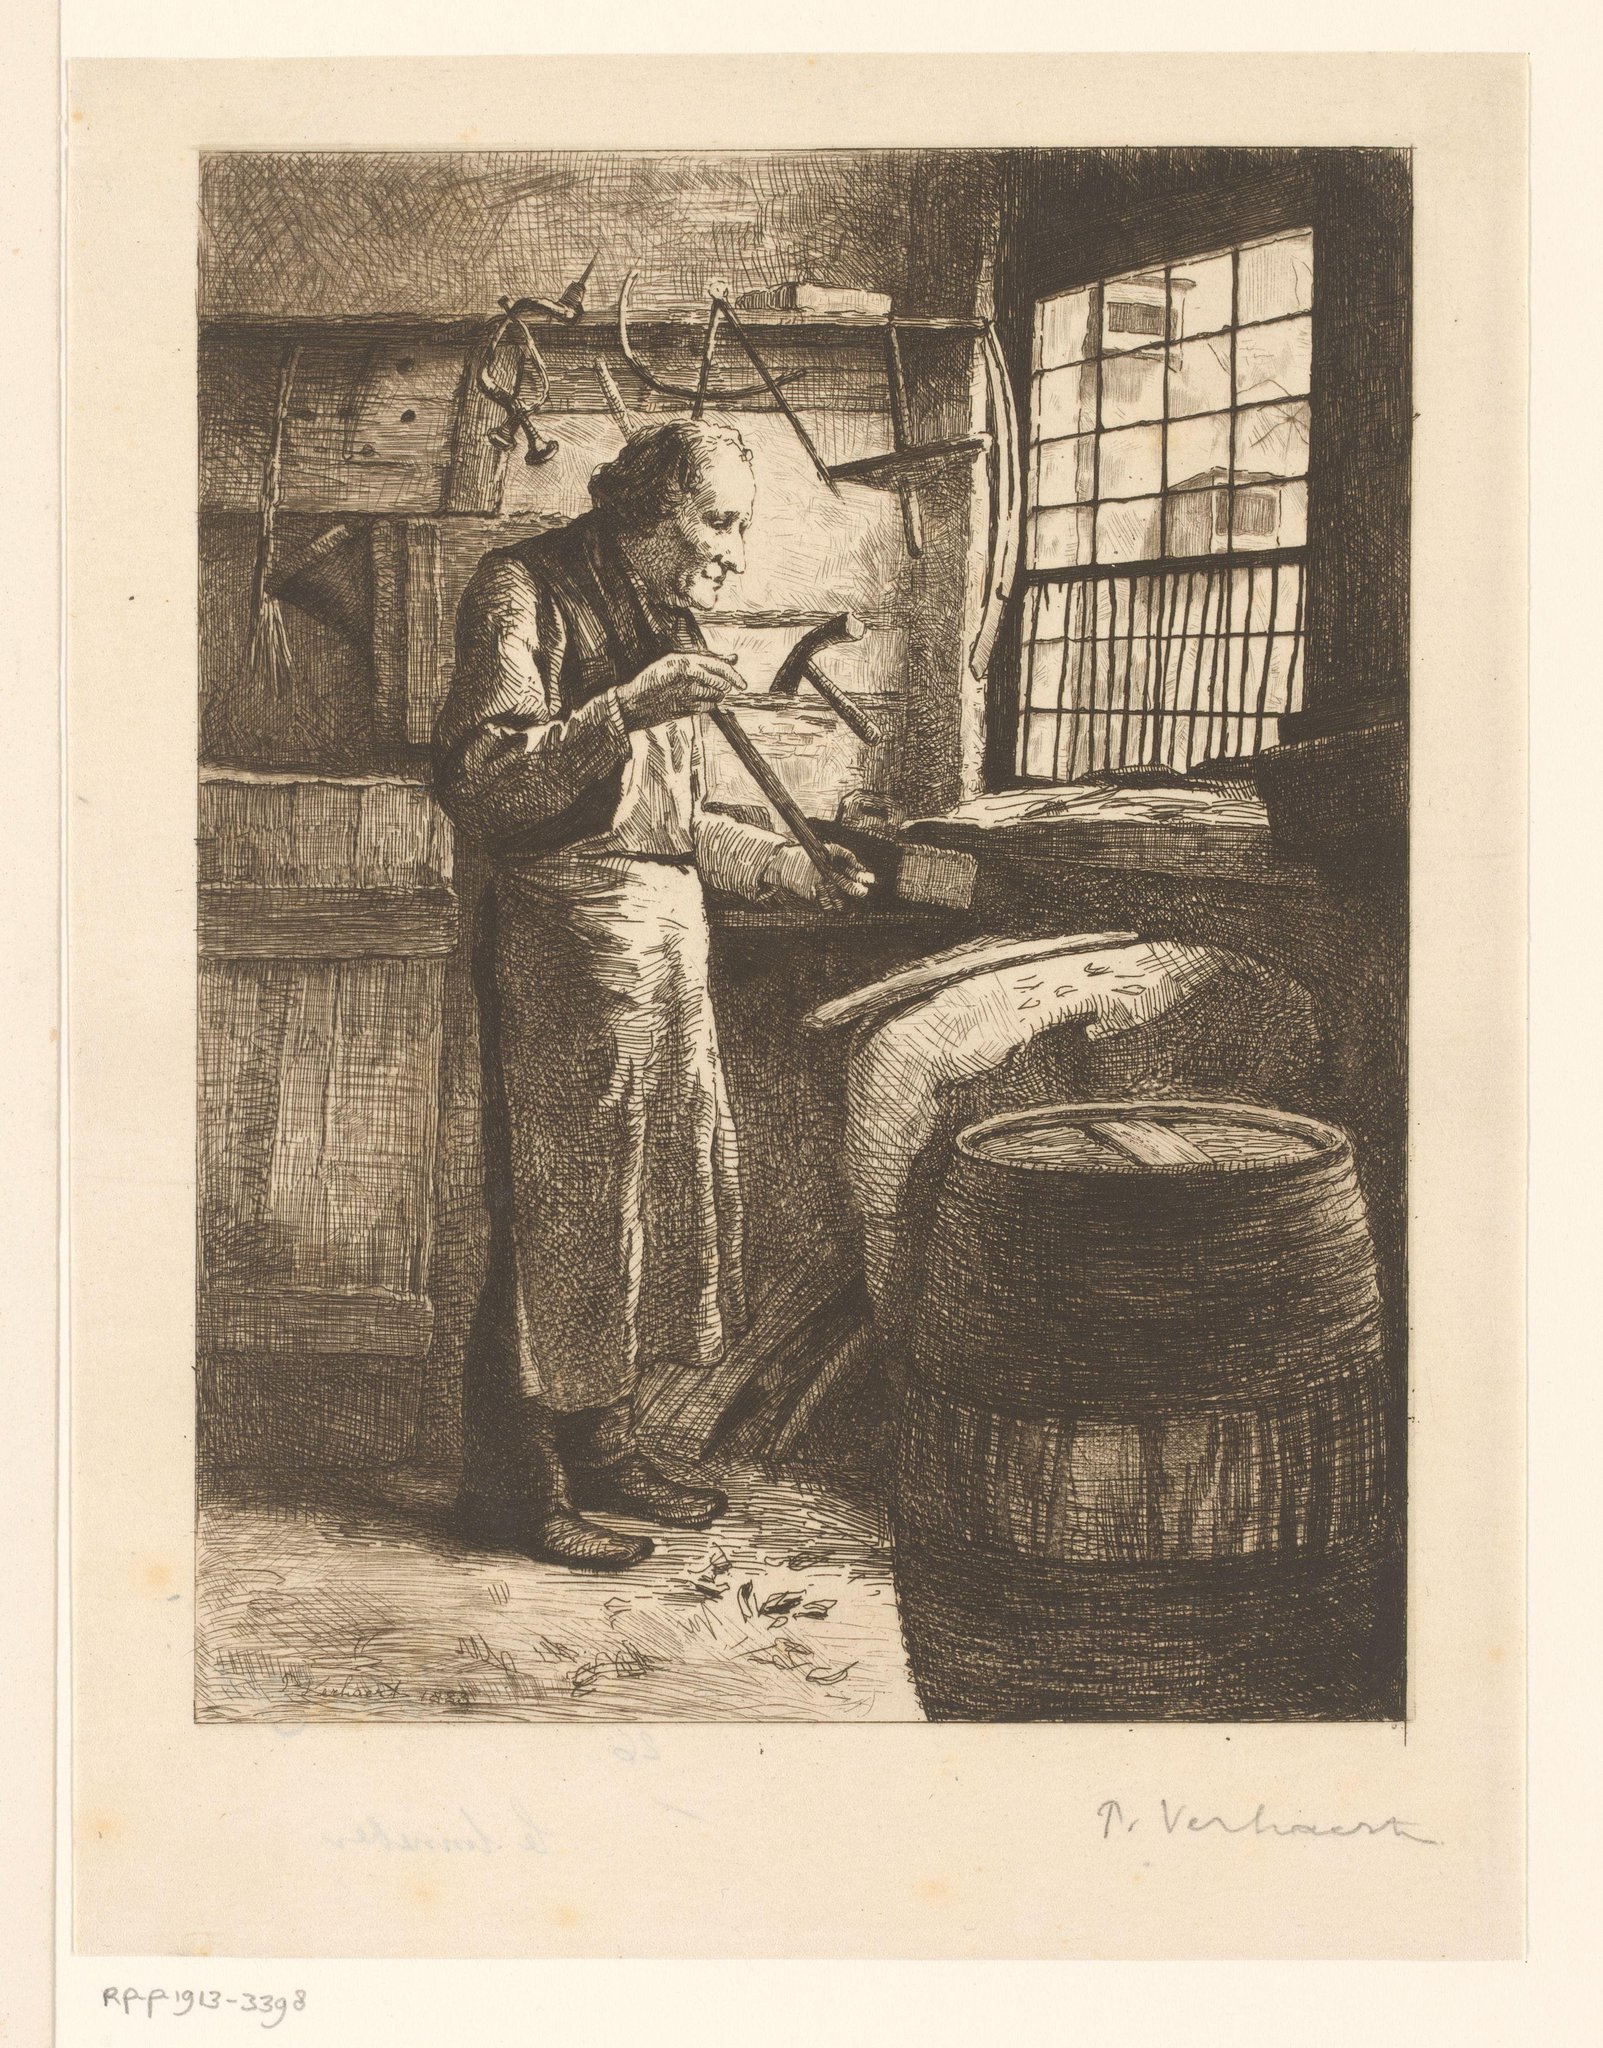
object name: print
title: Kuiper aan het werk in zijn werkplaats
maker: piet verhaert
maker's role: print maker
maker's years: 1852-1908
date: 1883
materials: paper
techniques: etching, retroussage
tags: handicrafts, craftsman at work, wooden container: barrel, cask, bucket, workshop-interior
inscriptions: collector's mark: Lugt 2228, mark: ‘Antwerpsche Etsers 1880’